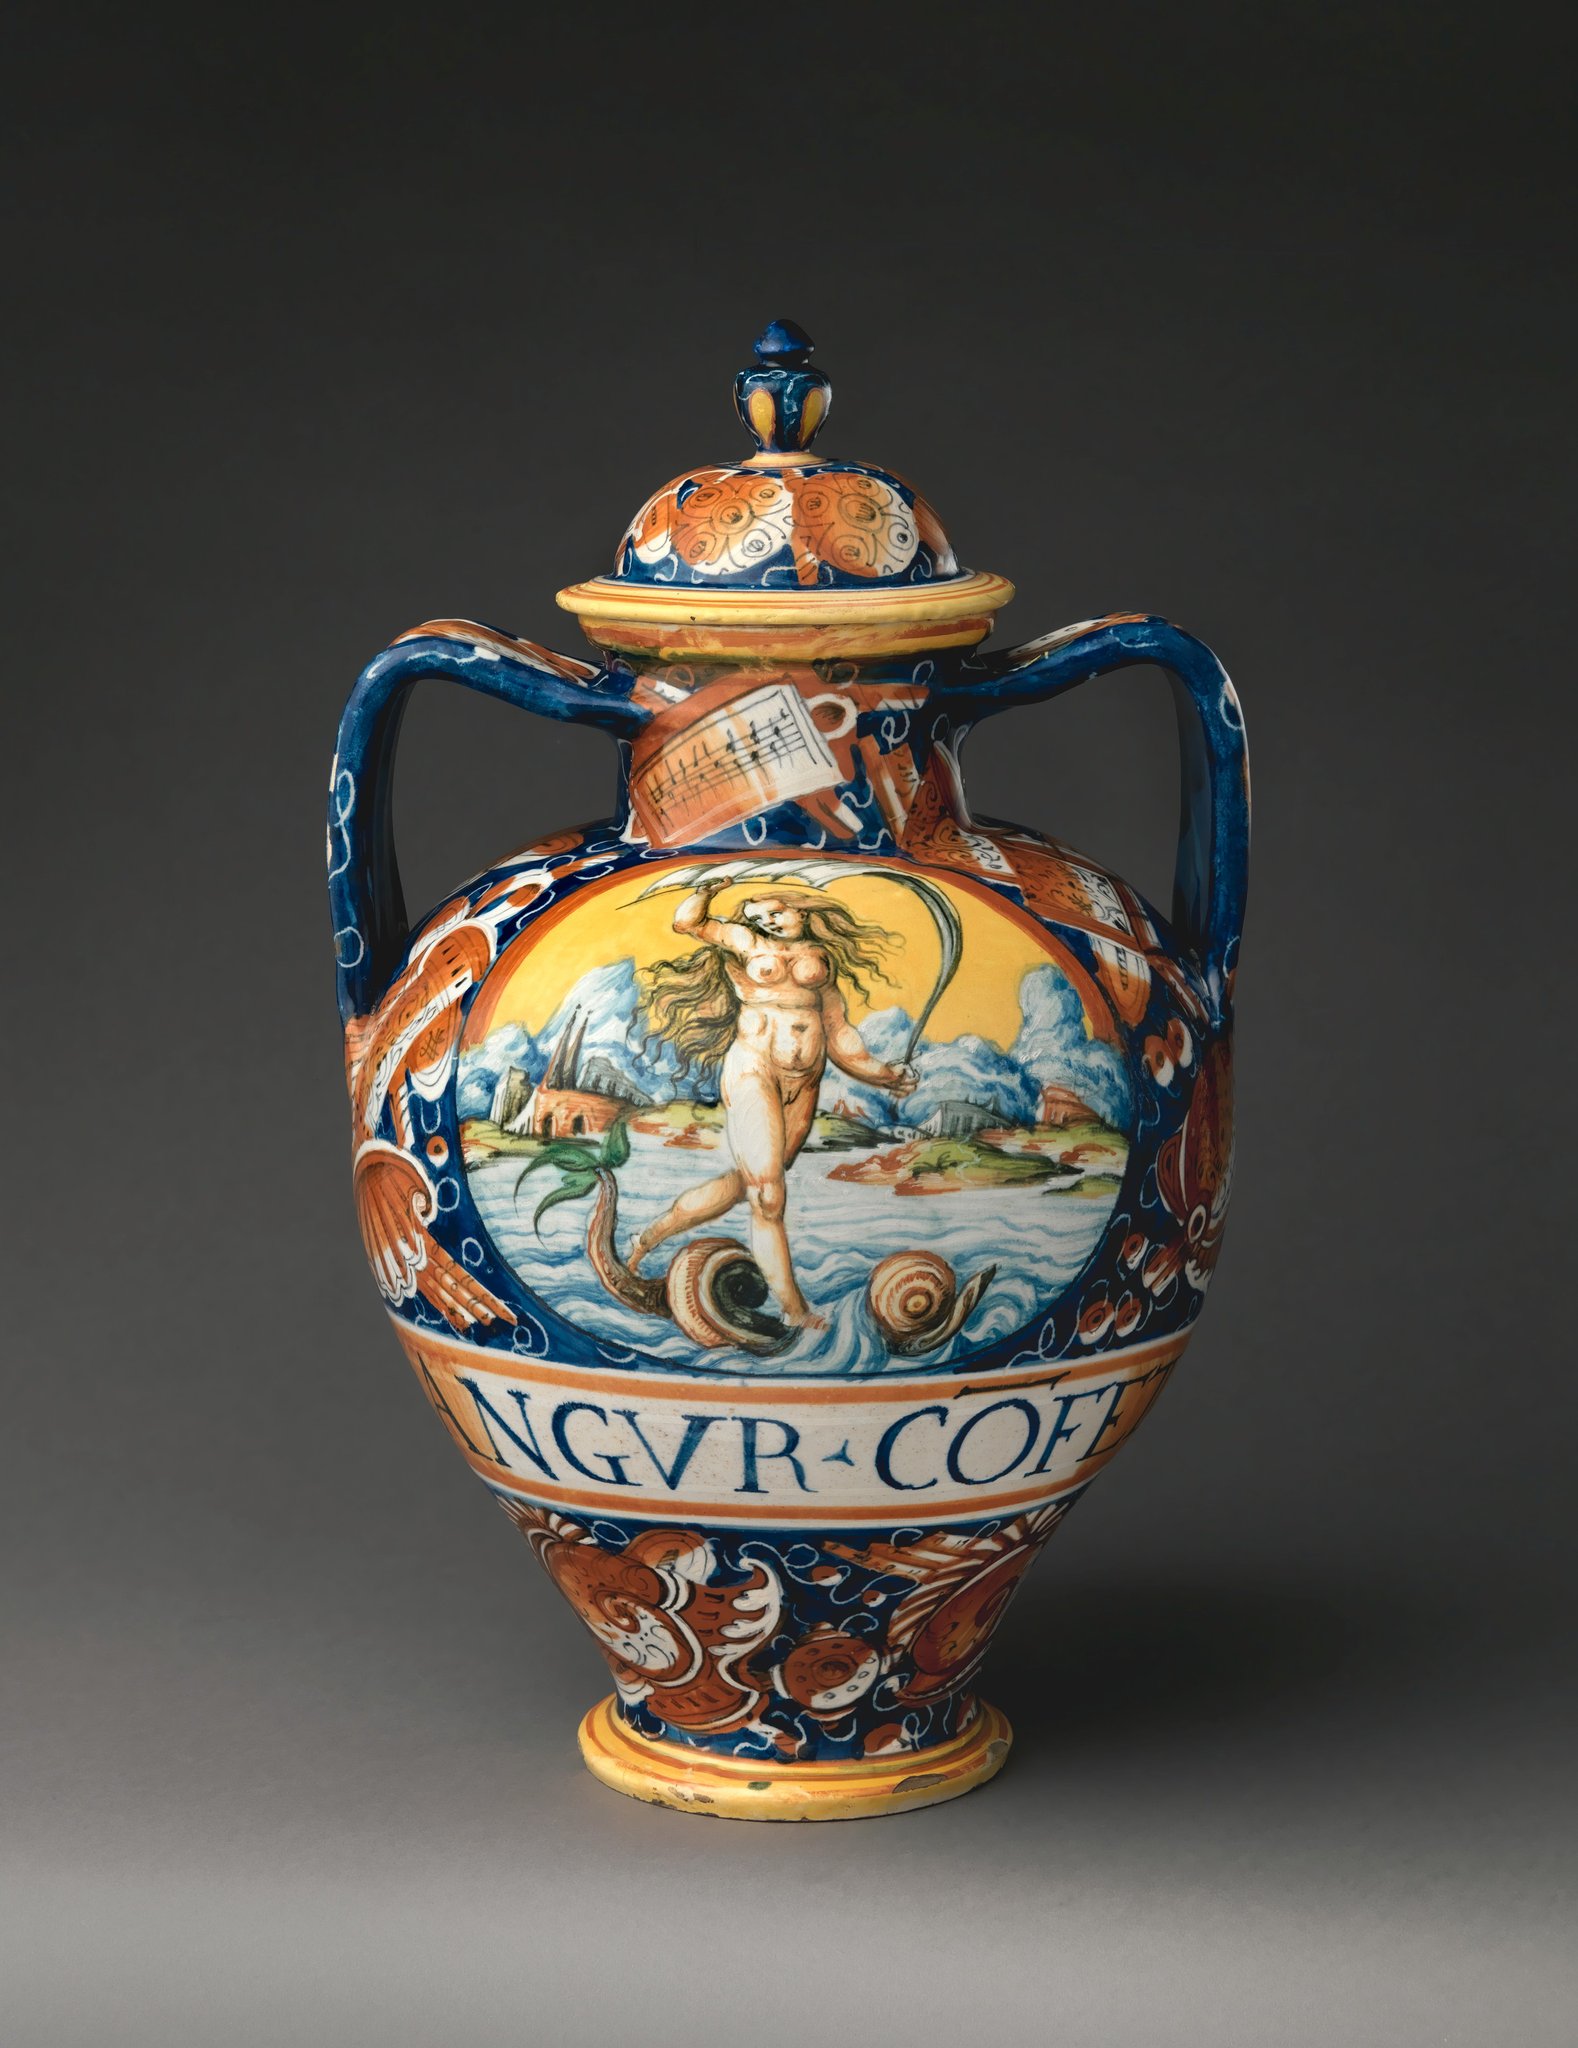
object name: pharmacy jar with cover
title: Lidded pharmacy jar with the personification of Fortuna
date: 1579-1580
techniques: maiolica, glazing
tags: goddess